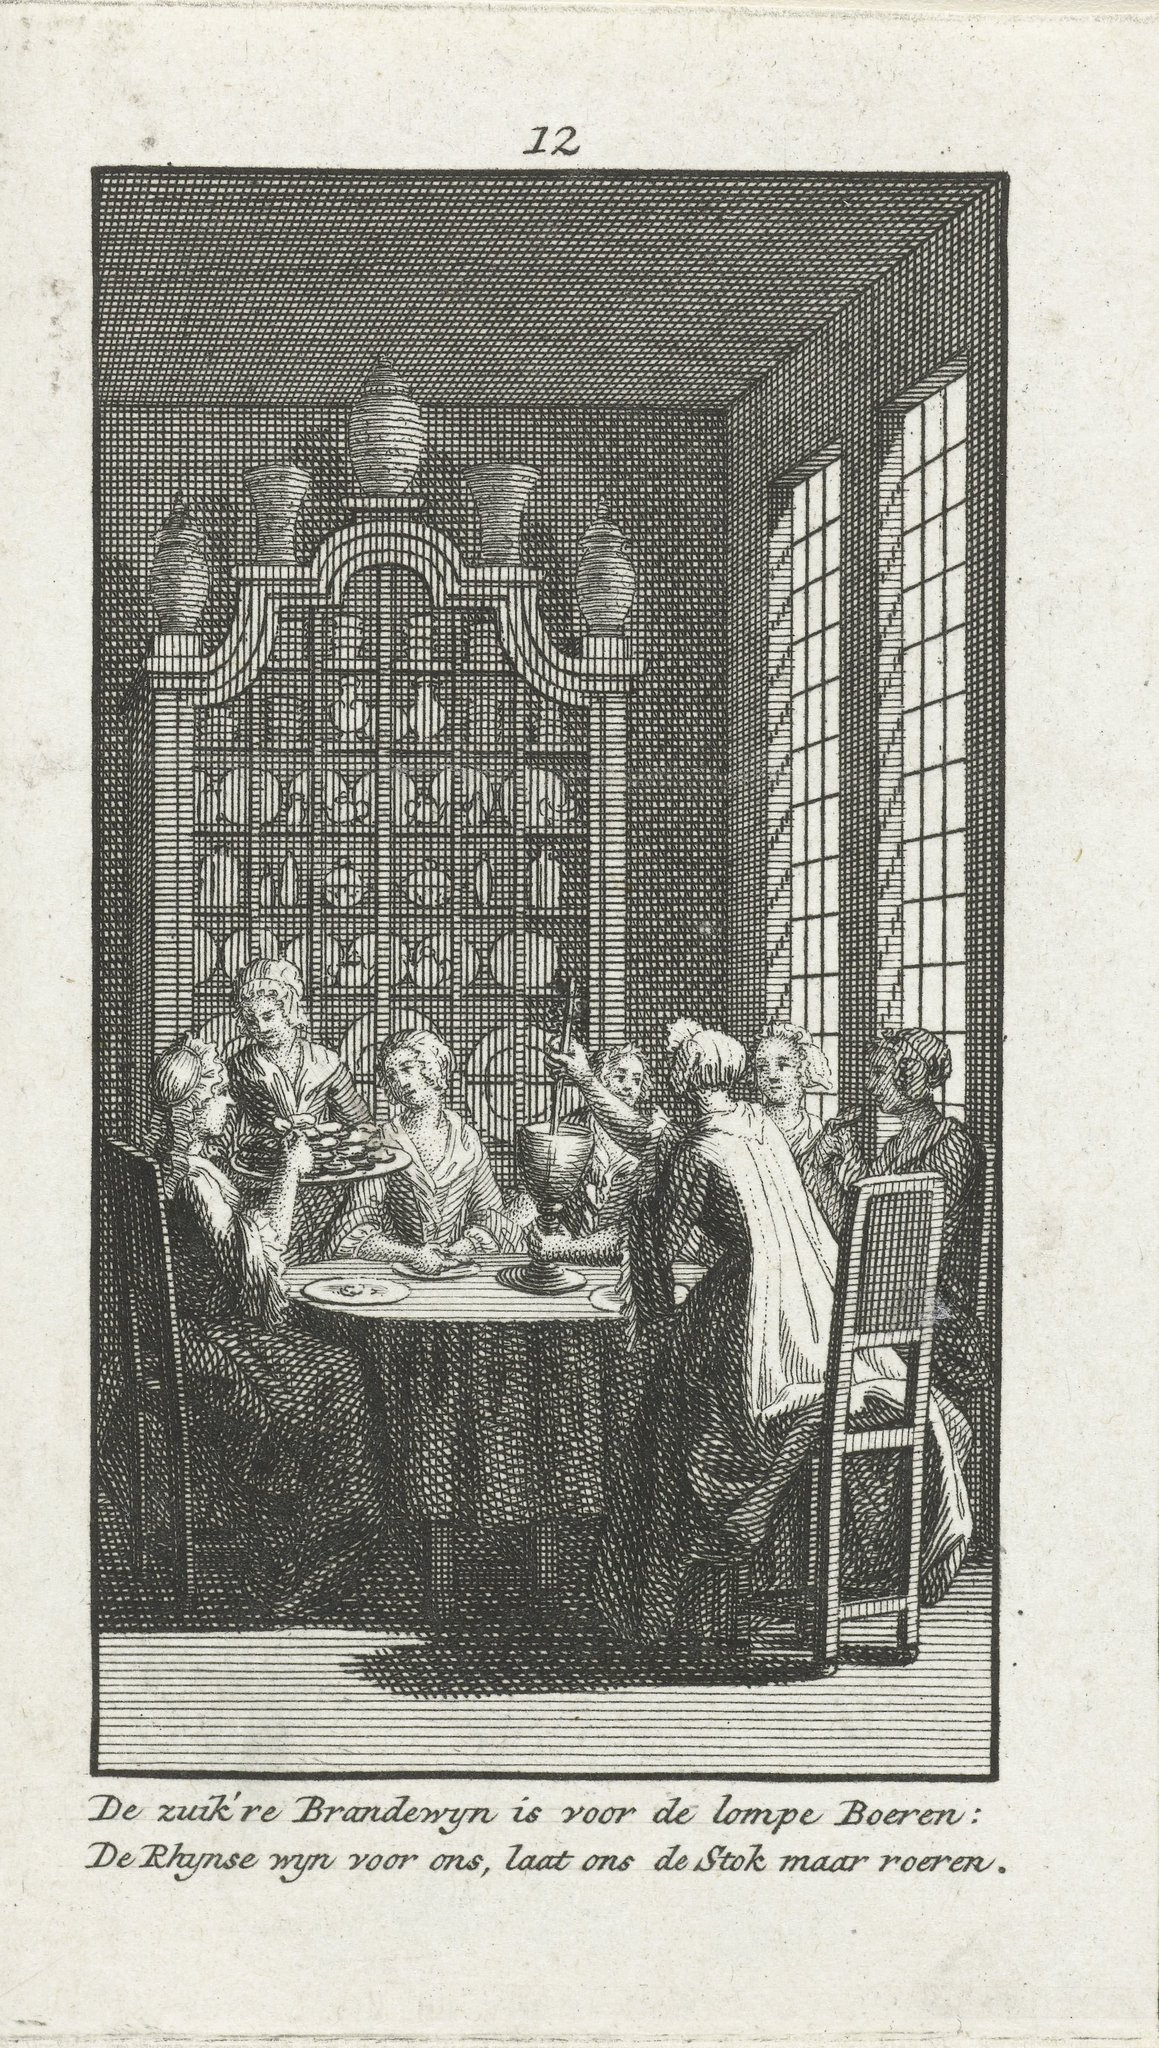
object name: print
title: Vrouwen op kraamvisite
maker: jan caspar philips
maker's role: draughtsman, print maker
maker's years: 1700-1775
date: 1740-1760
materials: paper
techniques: engraving, etching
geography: northern netherlands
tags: procreation, birth and (early) youth, wine ~ alcoholic drinks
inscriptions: collector's mark: Lugt 2228, caption: ‘De zuik're Brandewyn ... Stok maar roeren.’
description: Vrouwen op kraamvisite rond tafel met bokaal erop waaruit wijn opgeschept wordt. Prent nr. 2 in een serie van twaalf prentjes met tweeregelige versjes over de Hollandse gewoontes bij het huwelijk ca. 1750.